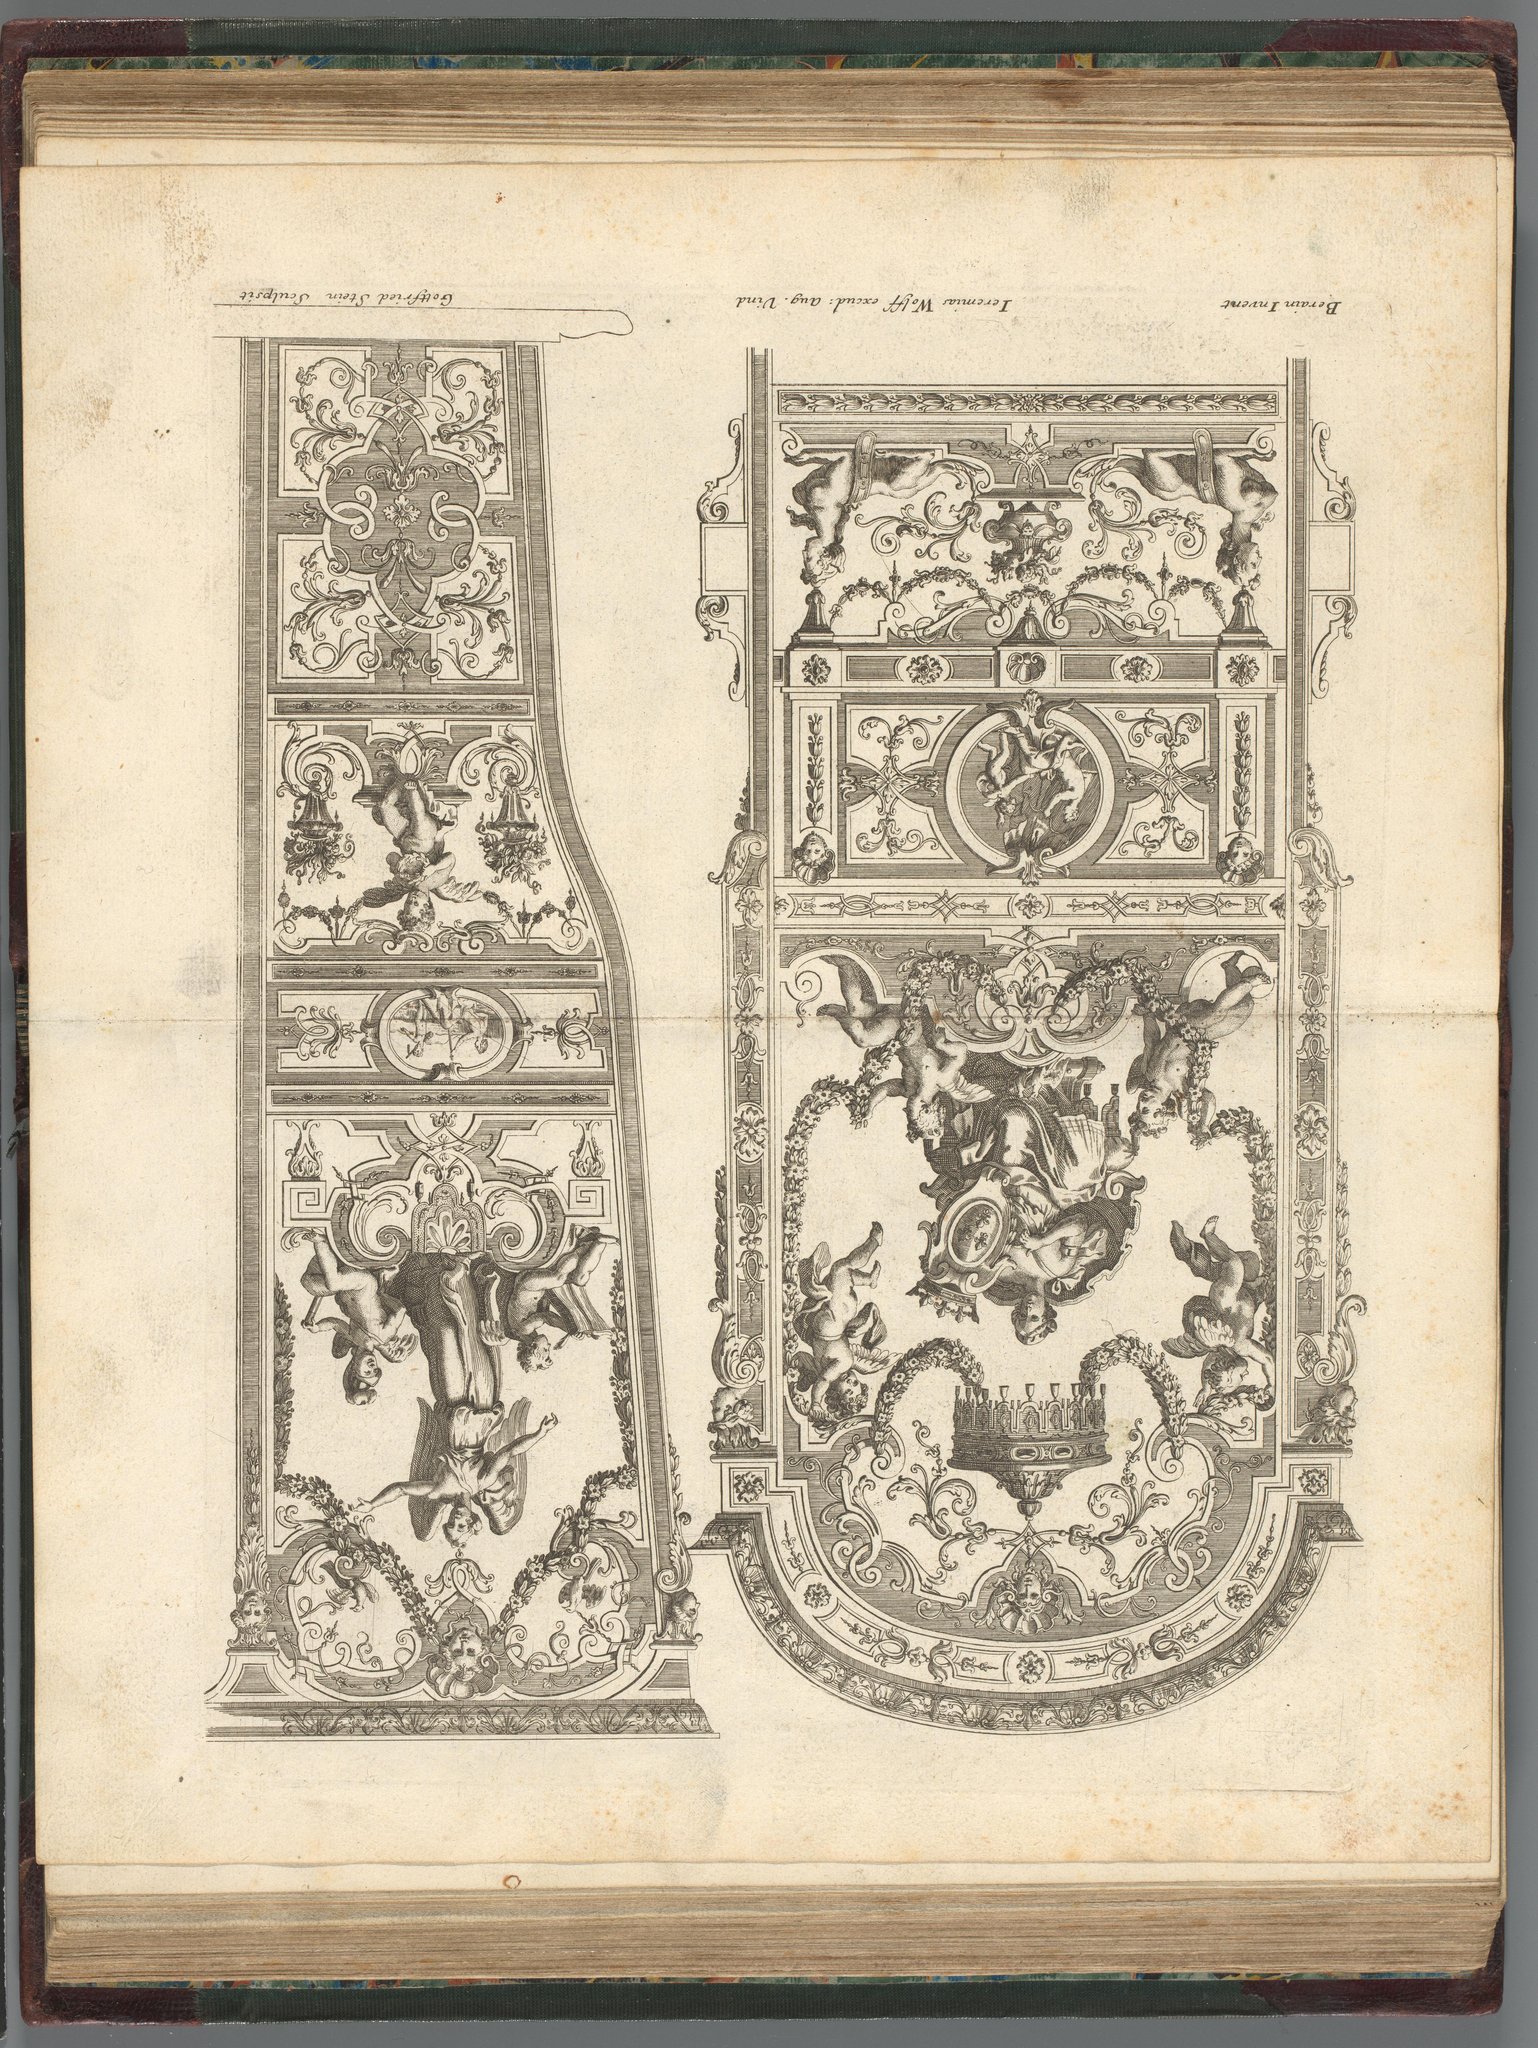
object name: print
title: Compositie met tronende vrouw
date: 1697-1724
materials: paper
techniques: etching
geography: augsburg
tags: sphinx (lion/woman); 'sfinge' (ripa) - aa - female human figure, ornaments ~ art, throne, venus punishing cupid, cupids: 'amores', 'amoretti', 'putti'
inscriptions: signature: ‘Ieremias Wolff excud. Aug. Vind.’, signature: ‘Berain Invent.’, signature: ‘Gottfried Stein Sculps.’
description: Een decoratieve compositie bestaand uit twee ontwerpen. Links een tronende vrouw die wijst op een wapenschild met drie Franse lelies. Ze wordt omringd door putti die guirlandes vasthouden. Daaronder een scène in een medaillon van Venus die de boog van Amor afpakt. Daaronder twee sfinxen. Rechts een staande engel vergezeld door twee putti. Prent maakt deel uit van een album. Hoogstwaarschijnlijk gespiegelde kopie naar Frans origineel.